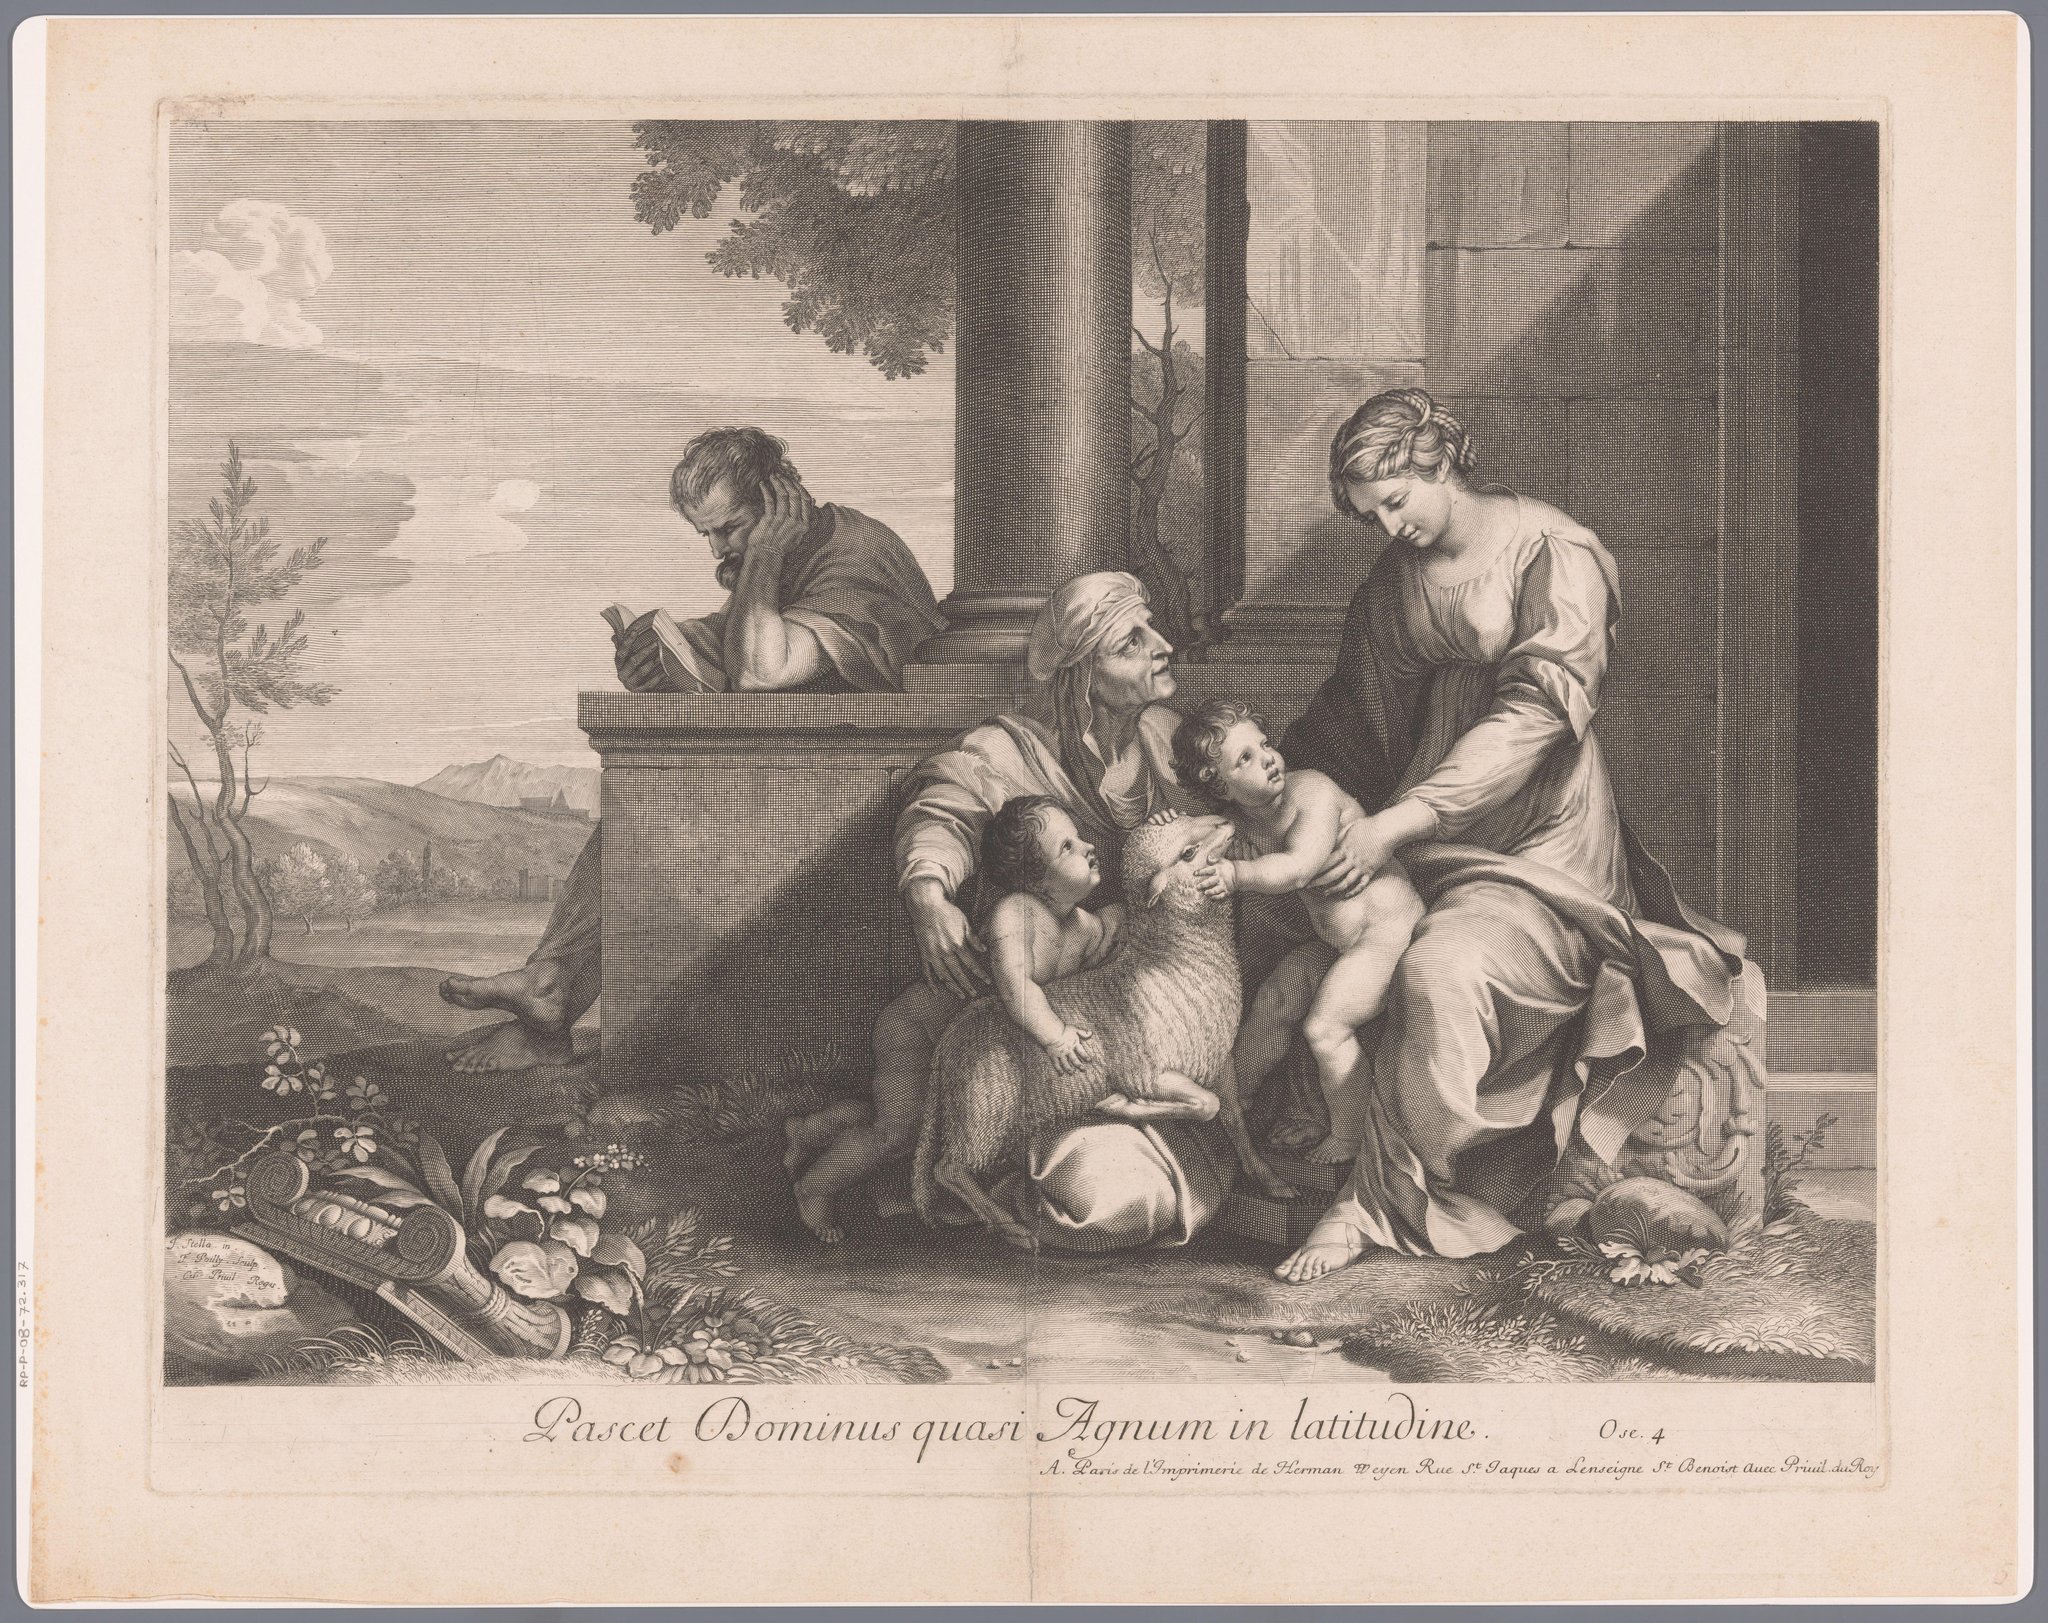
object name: print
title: Heilige Familie met Elisabet en Johannes de Doper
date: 1632-1693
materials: paper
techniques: engraving, etching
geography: france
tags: holy family, and derived representations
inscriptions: collector's mark: Lugt 240